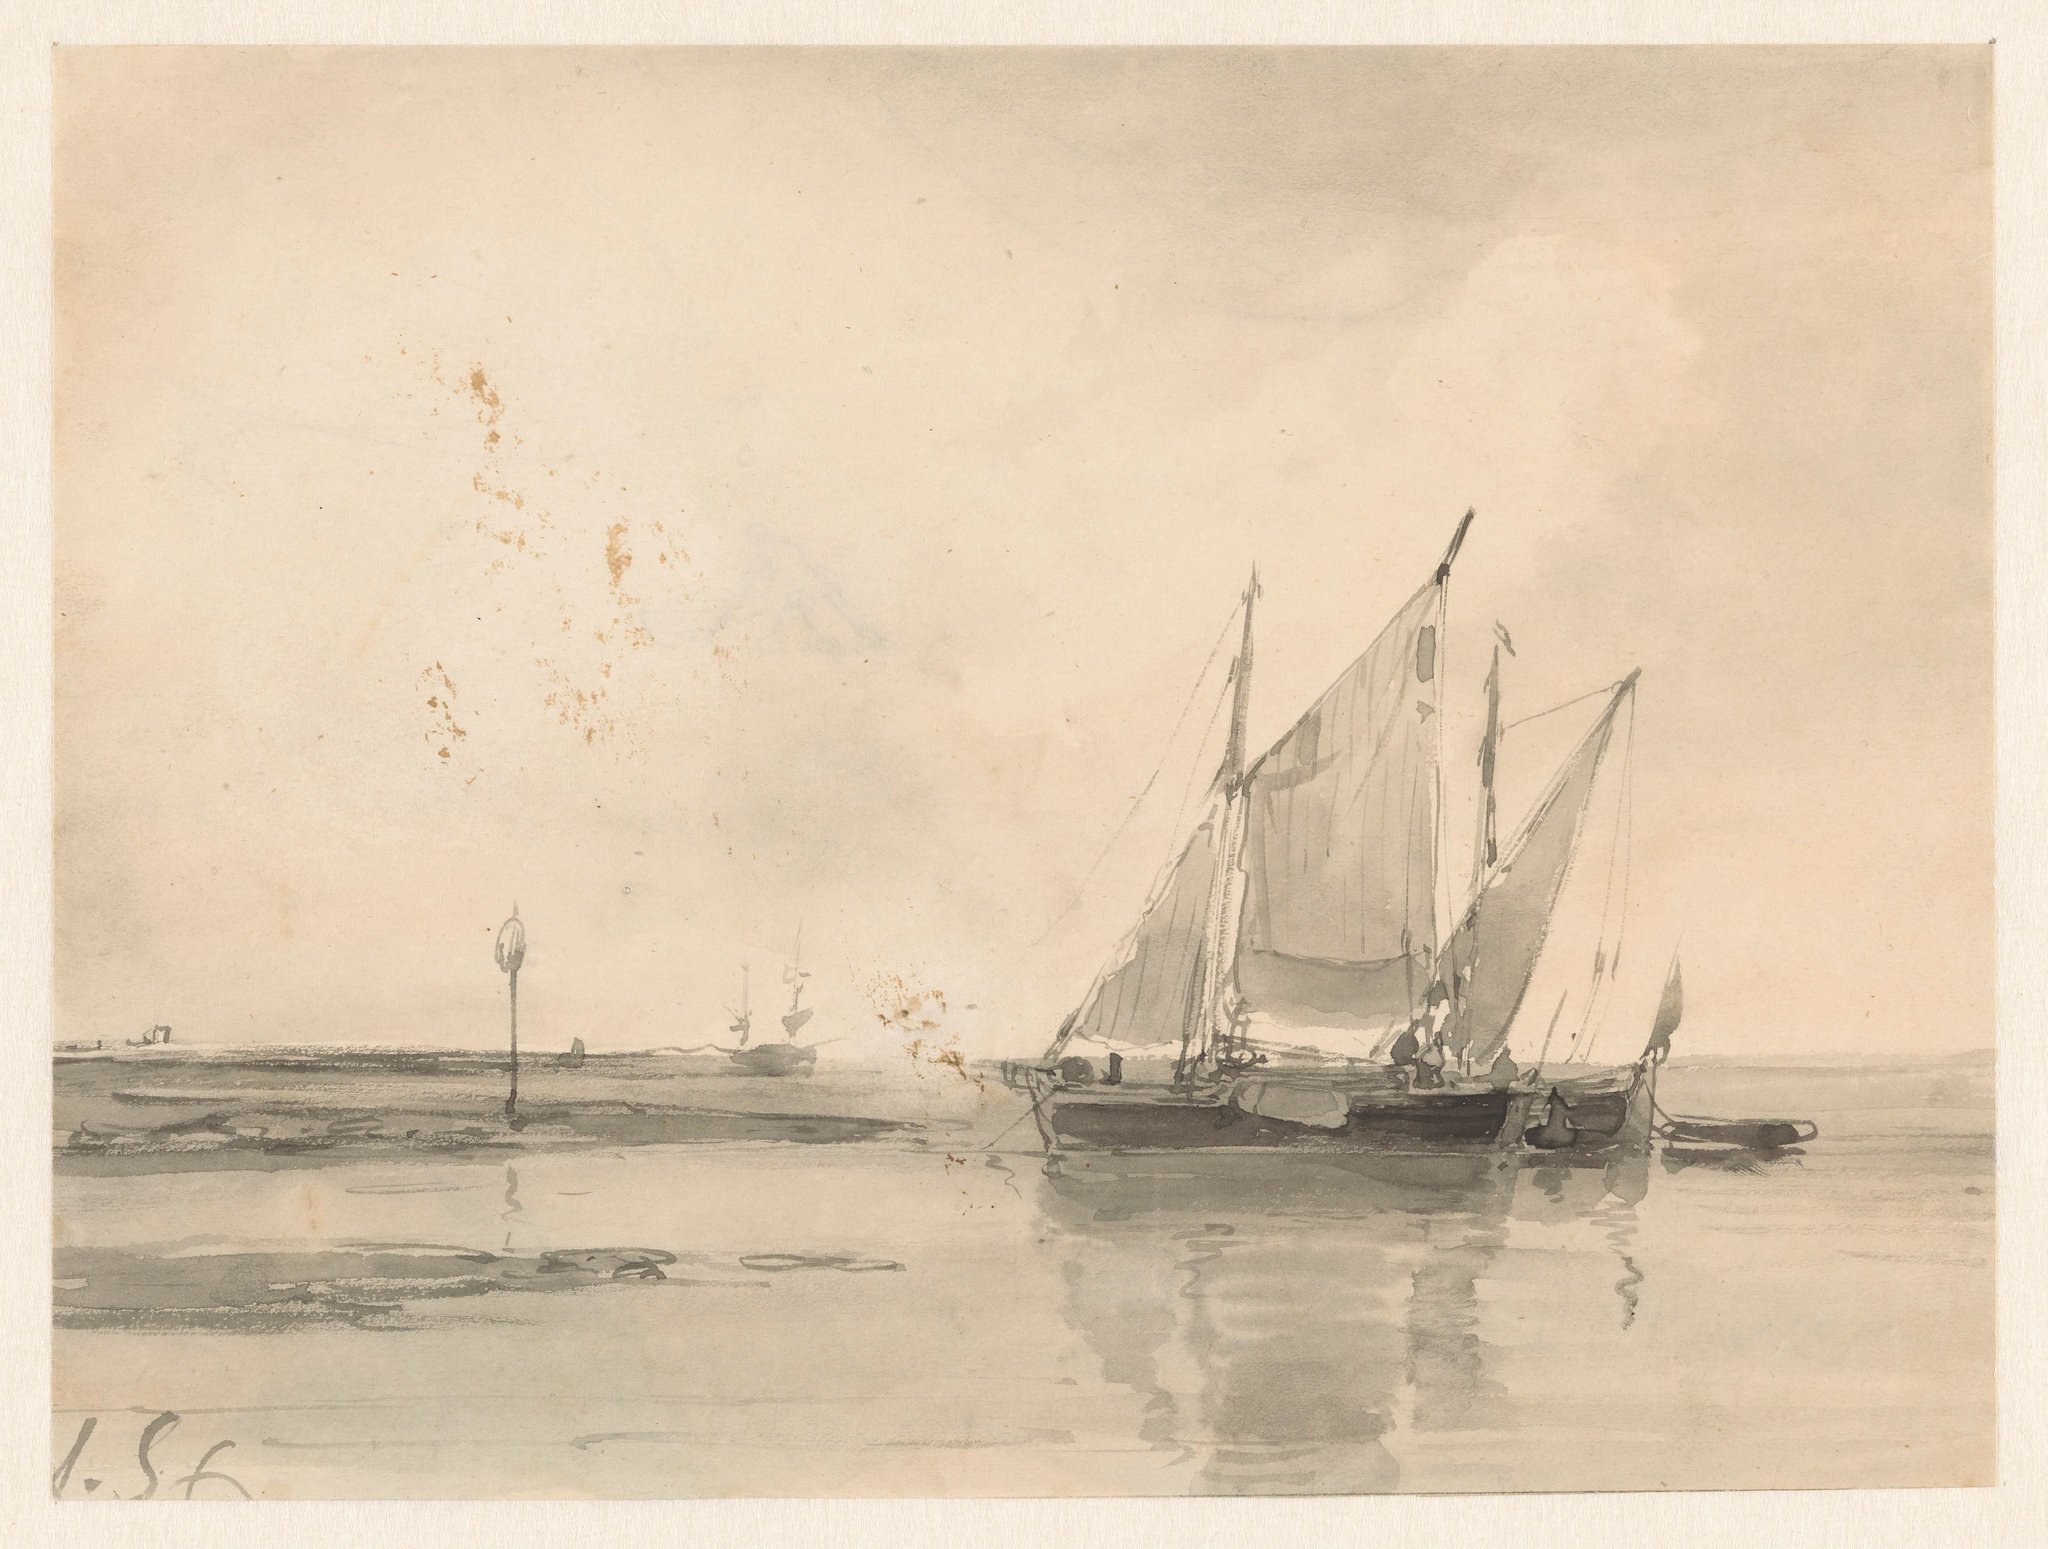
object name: drawing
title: Twee schepen op een kalme rivier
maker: andreas schelfhout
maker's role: draughtsman, painter, print maker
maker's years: 1787-1870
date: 1797-1870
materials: paper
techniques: brush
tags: commercial fishery, river, ships (in general)